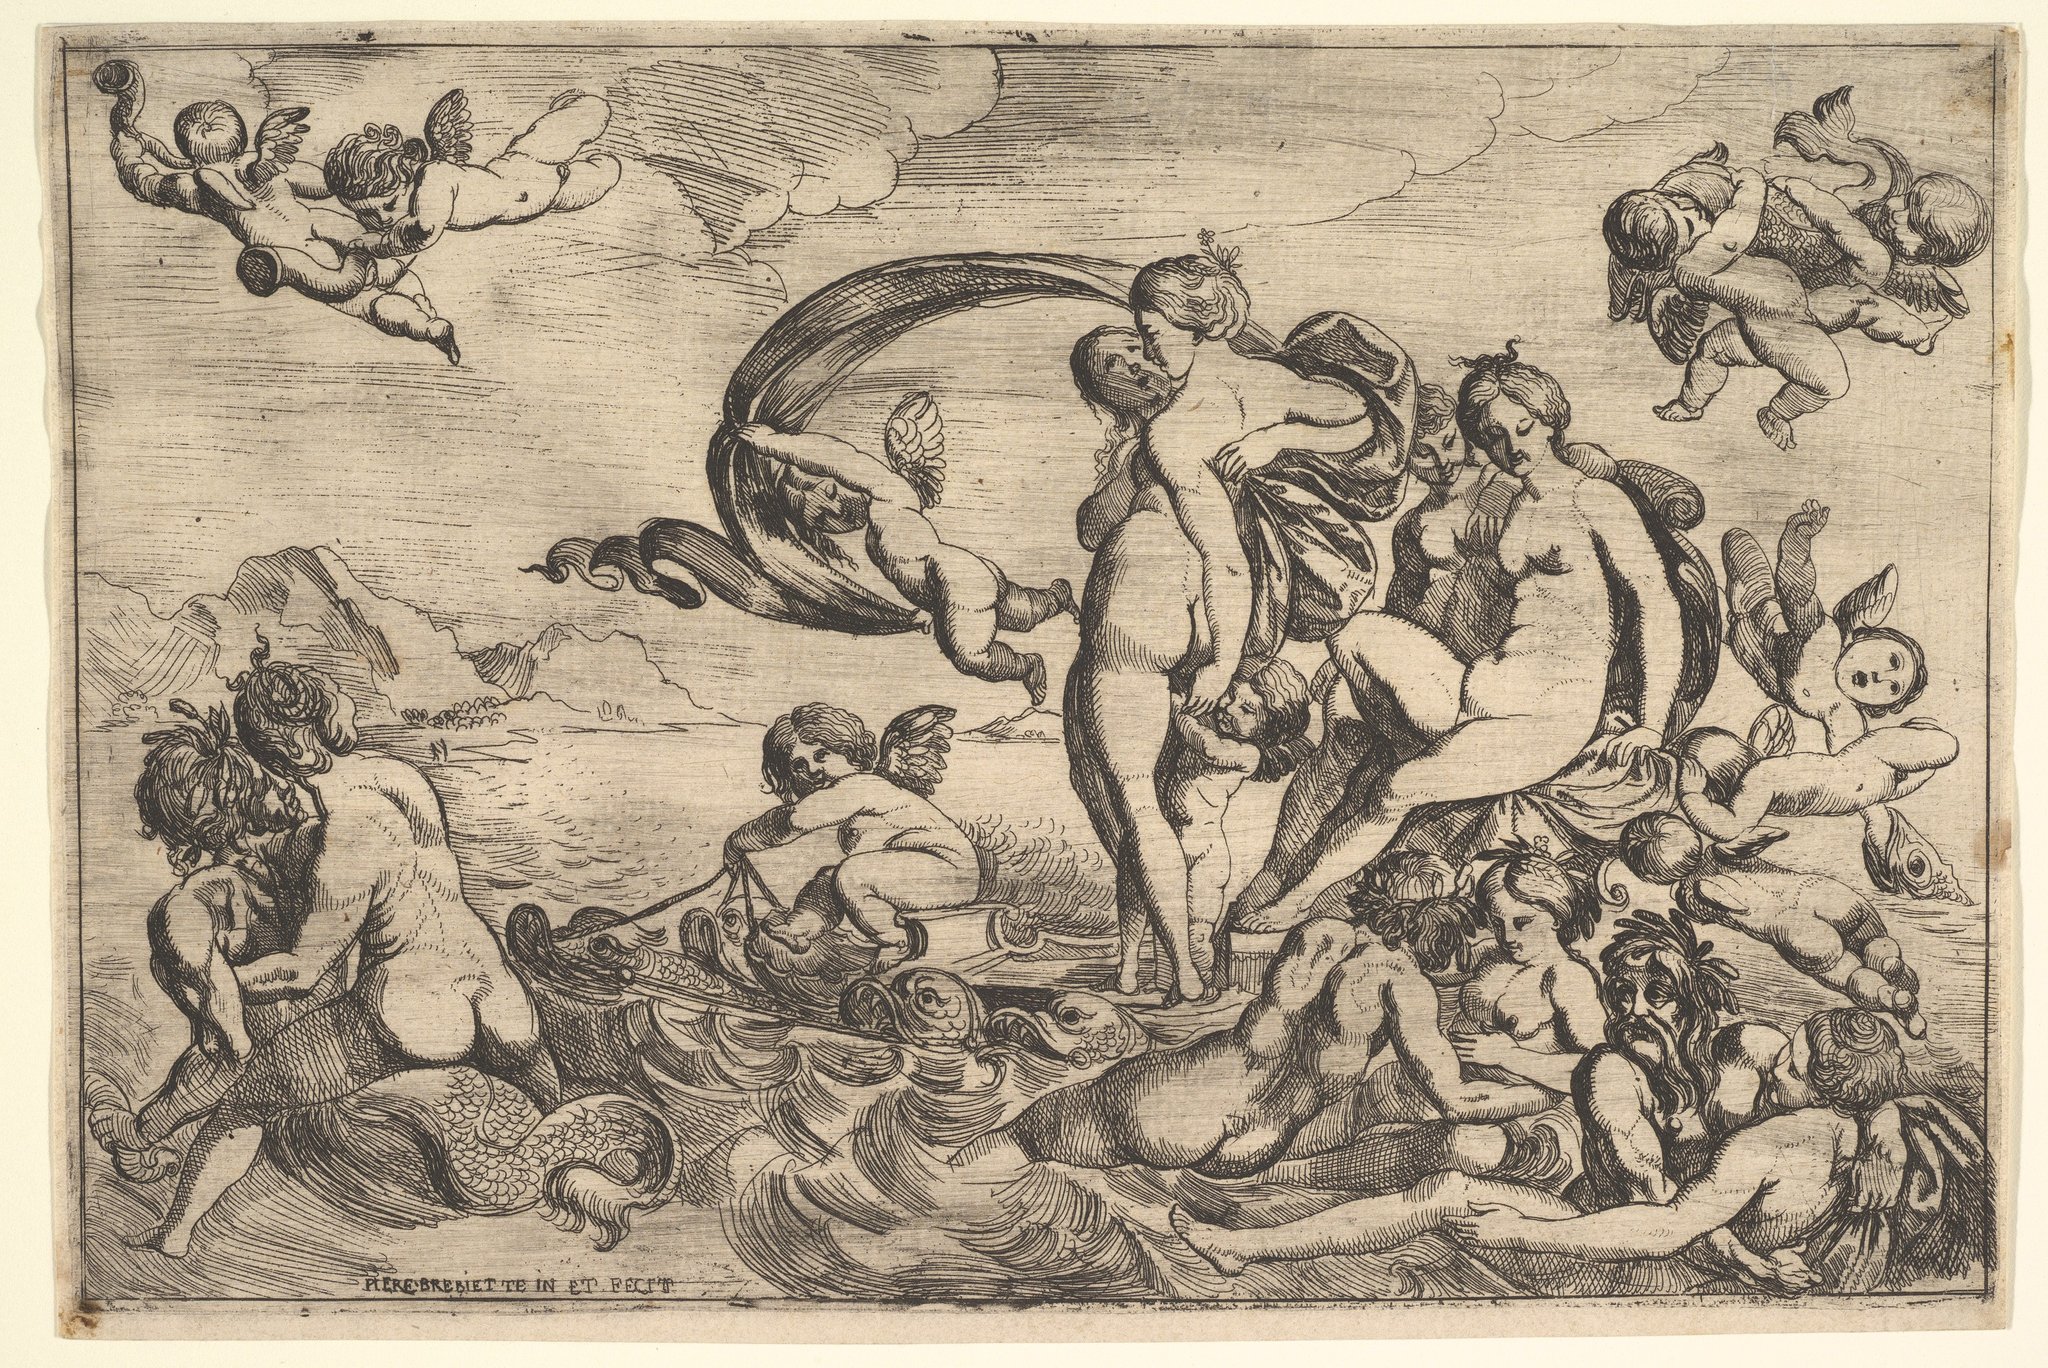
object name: print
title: Venus on a Chariot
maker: pierre brebiette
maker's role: artist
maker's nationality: french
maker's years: 1598-1642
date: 1640-1649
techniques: etching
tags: putti,venus,fish,chariots